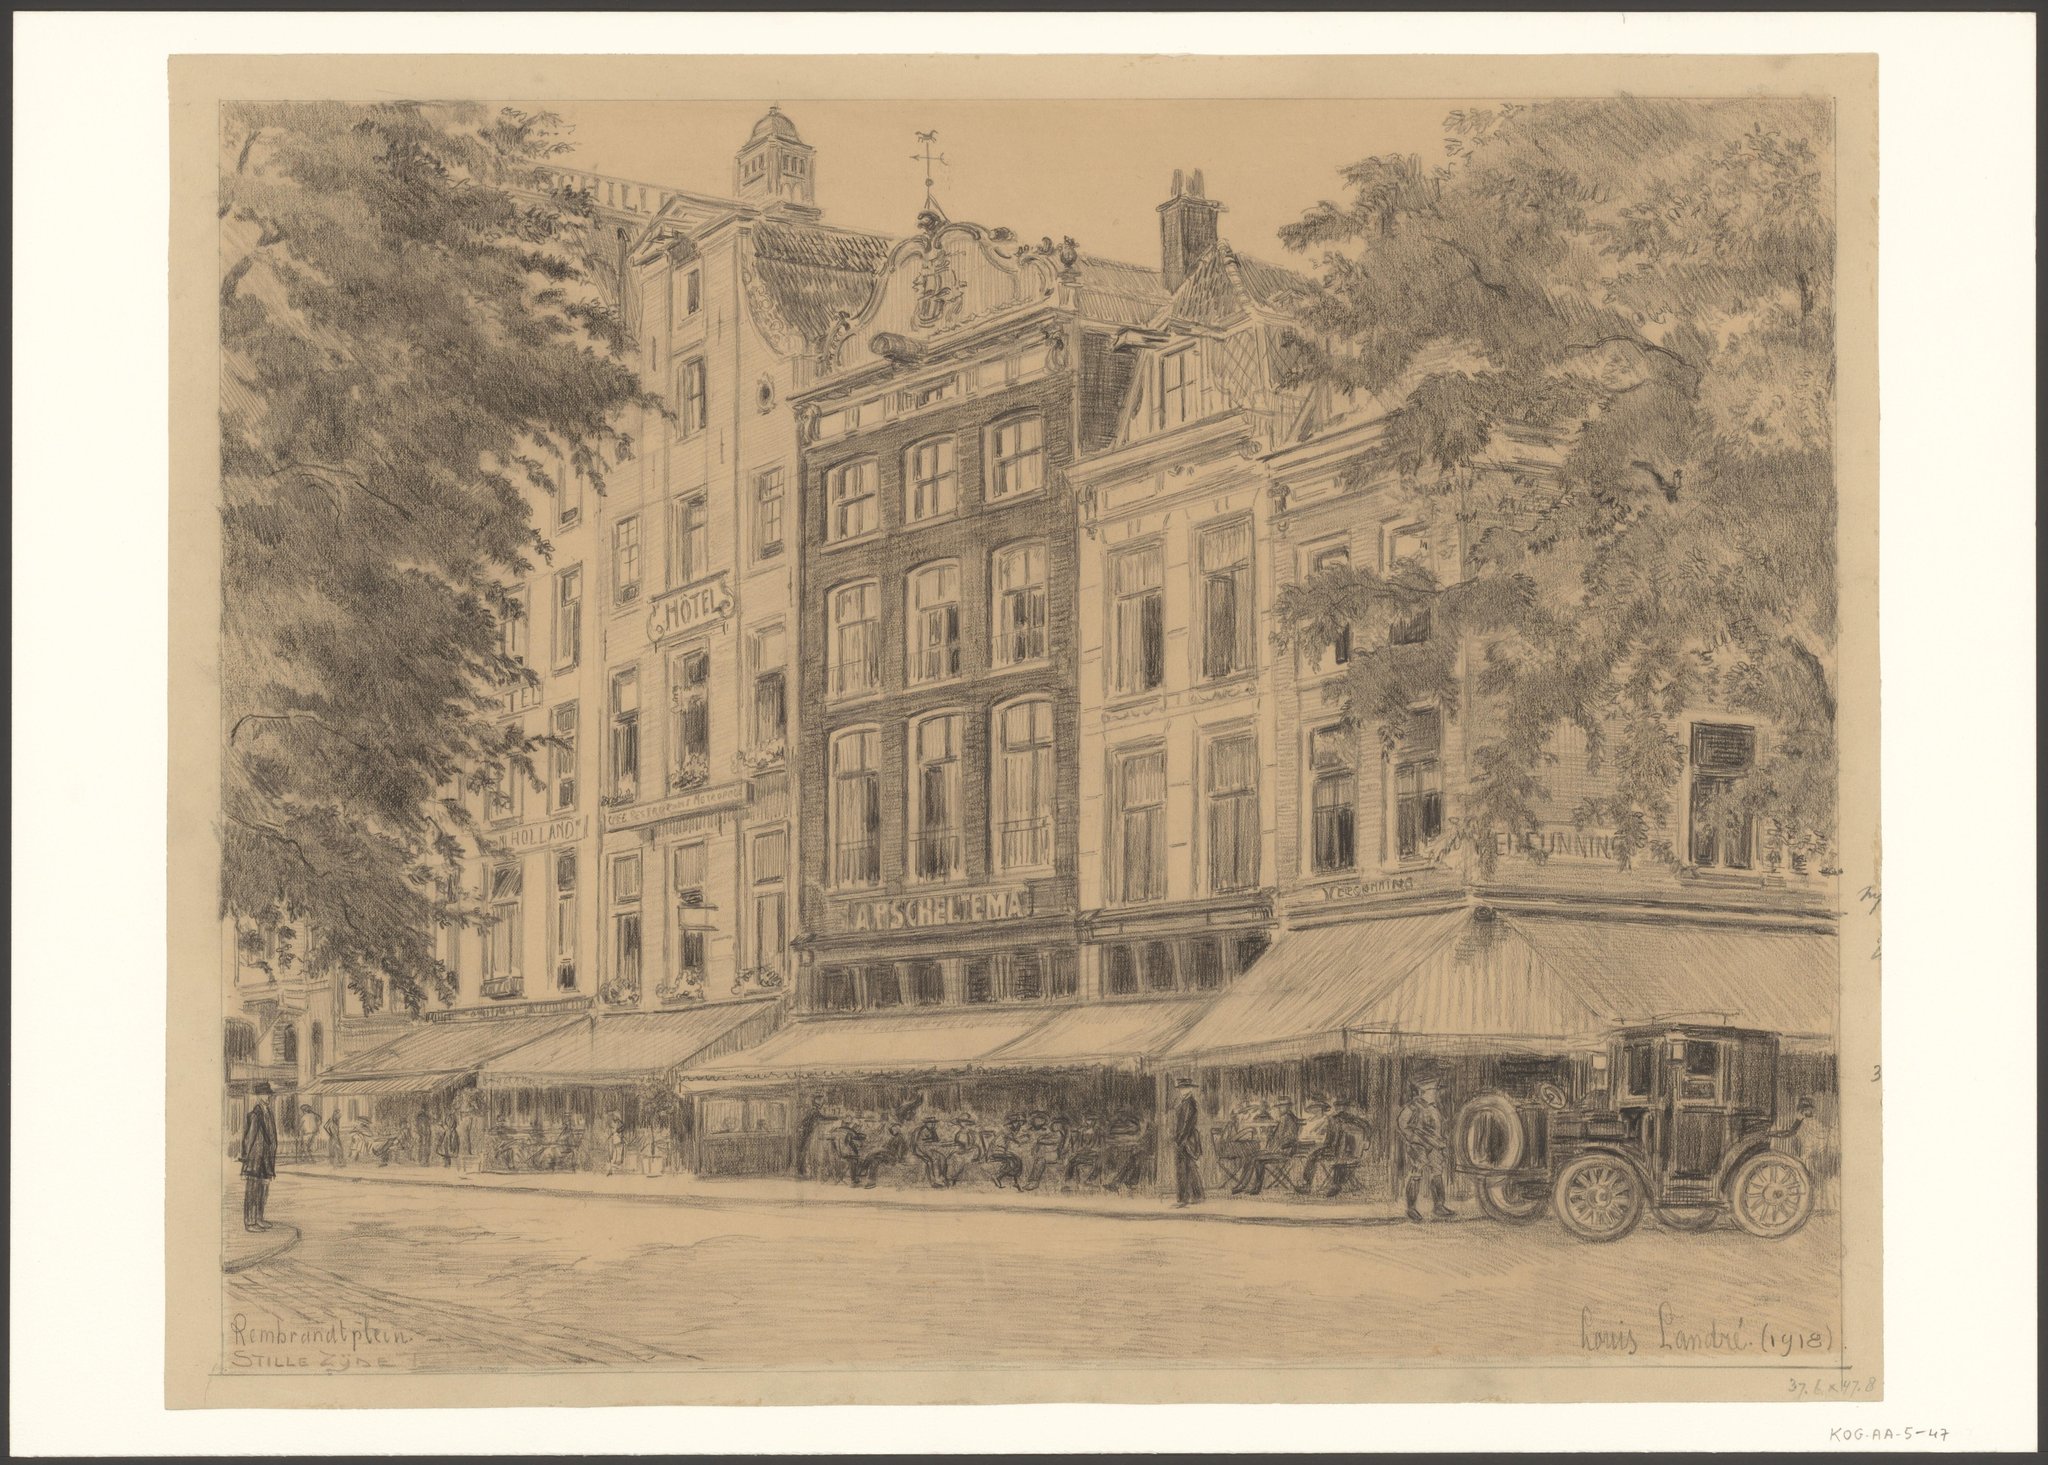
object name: drawing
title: Gezicht op het Rembrandtplein, hoek Thorbeckeplein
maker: jean charles louis landré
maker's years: 1875-1952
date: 1918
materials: chalk, paper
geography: amsterdam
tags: square, place, circus, etc., city-view in general; 'veduta', the usual house or row of houses, street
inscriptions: number: ‘60’, signature, date and inscription: ‘Rembrandtplein. / Stille Zijde / Louis Landré. (1918) / 37.6 x 47.8’, number: ‘60’